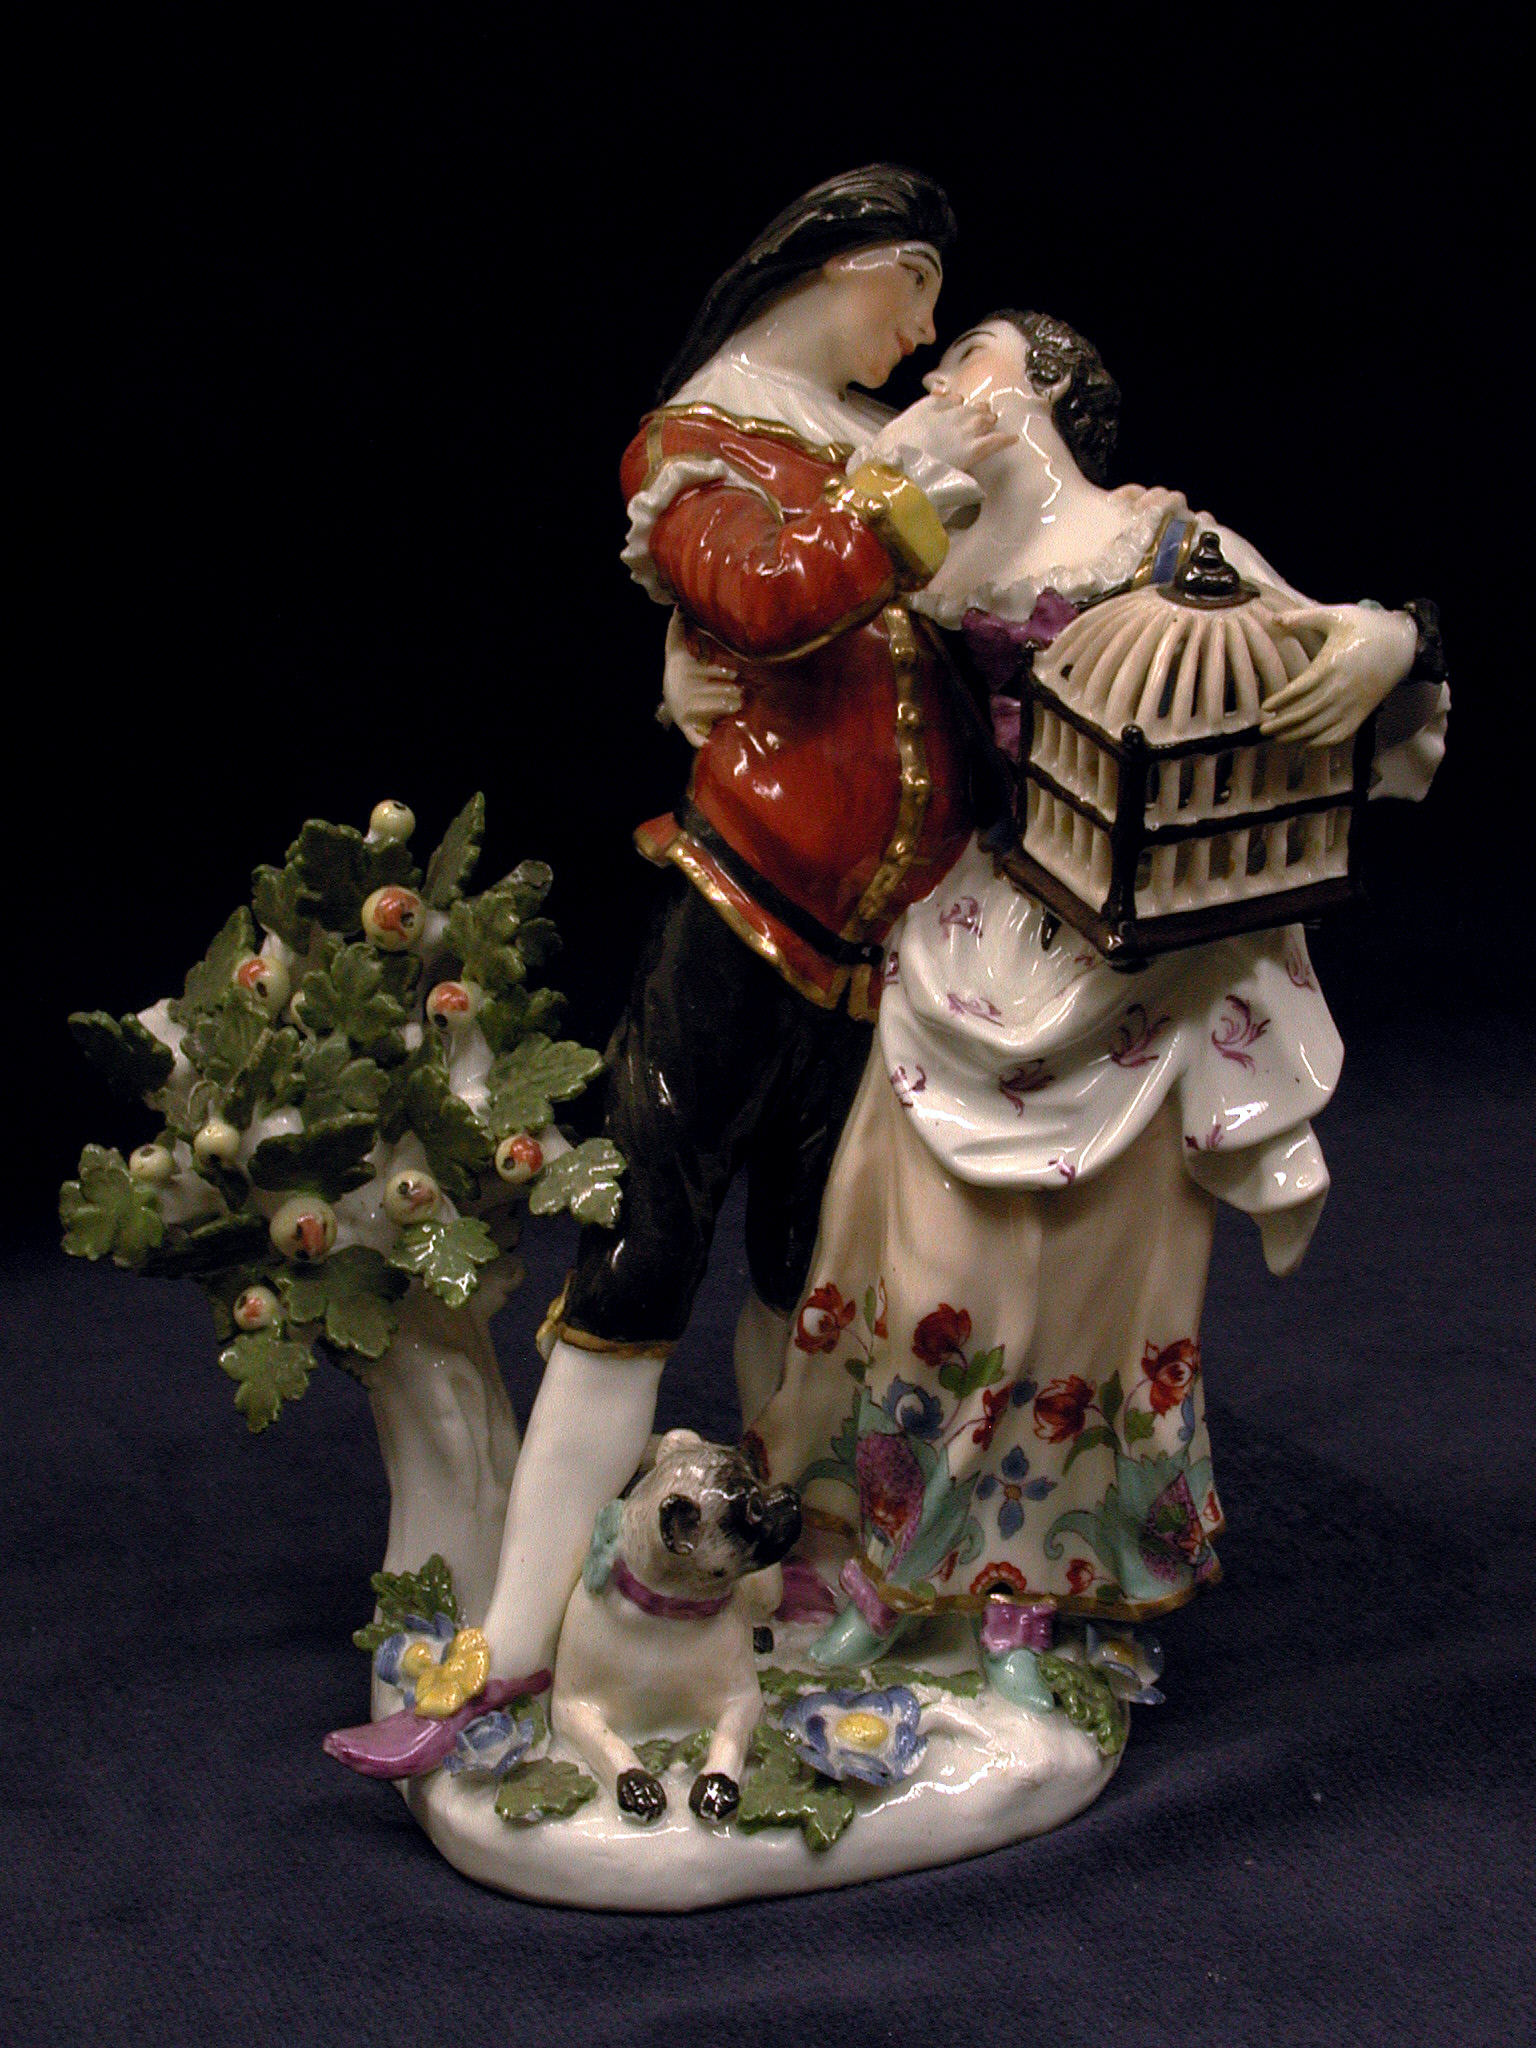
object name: group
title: Scaramouche and Columbine embracing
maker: meissen manufactory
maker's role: manufactory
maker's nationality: german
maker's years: 1710-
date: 1741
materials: hard paste porcelain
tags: couples,men,women,dogs